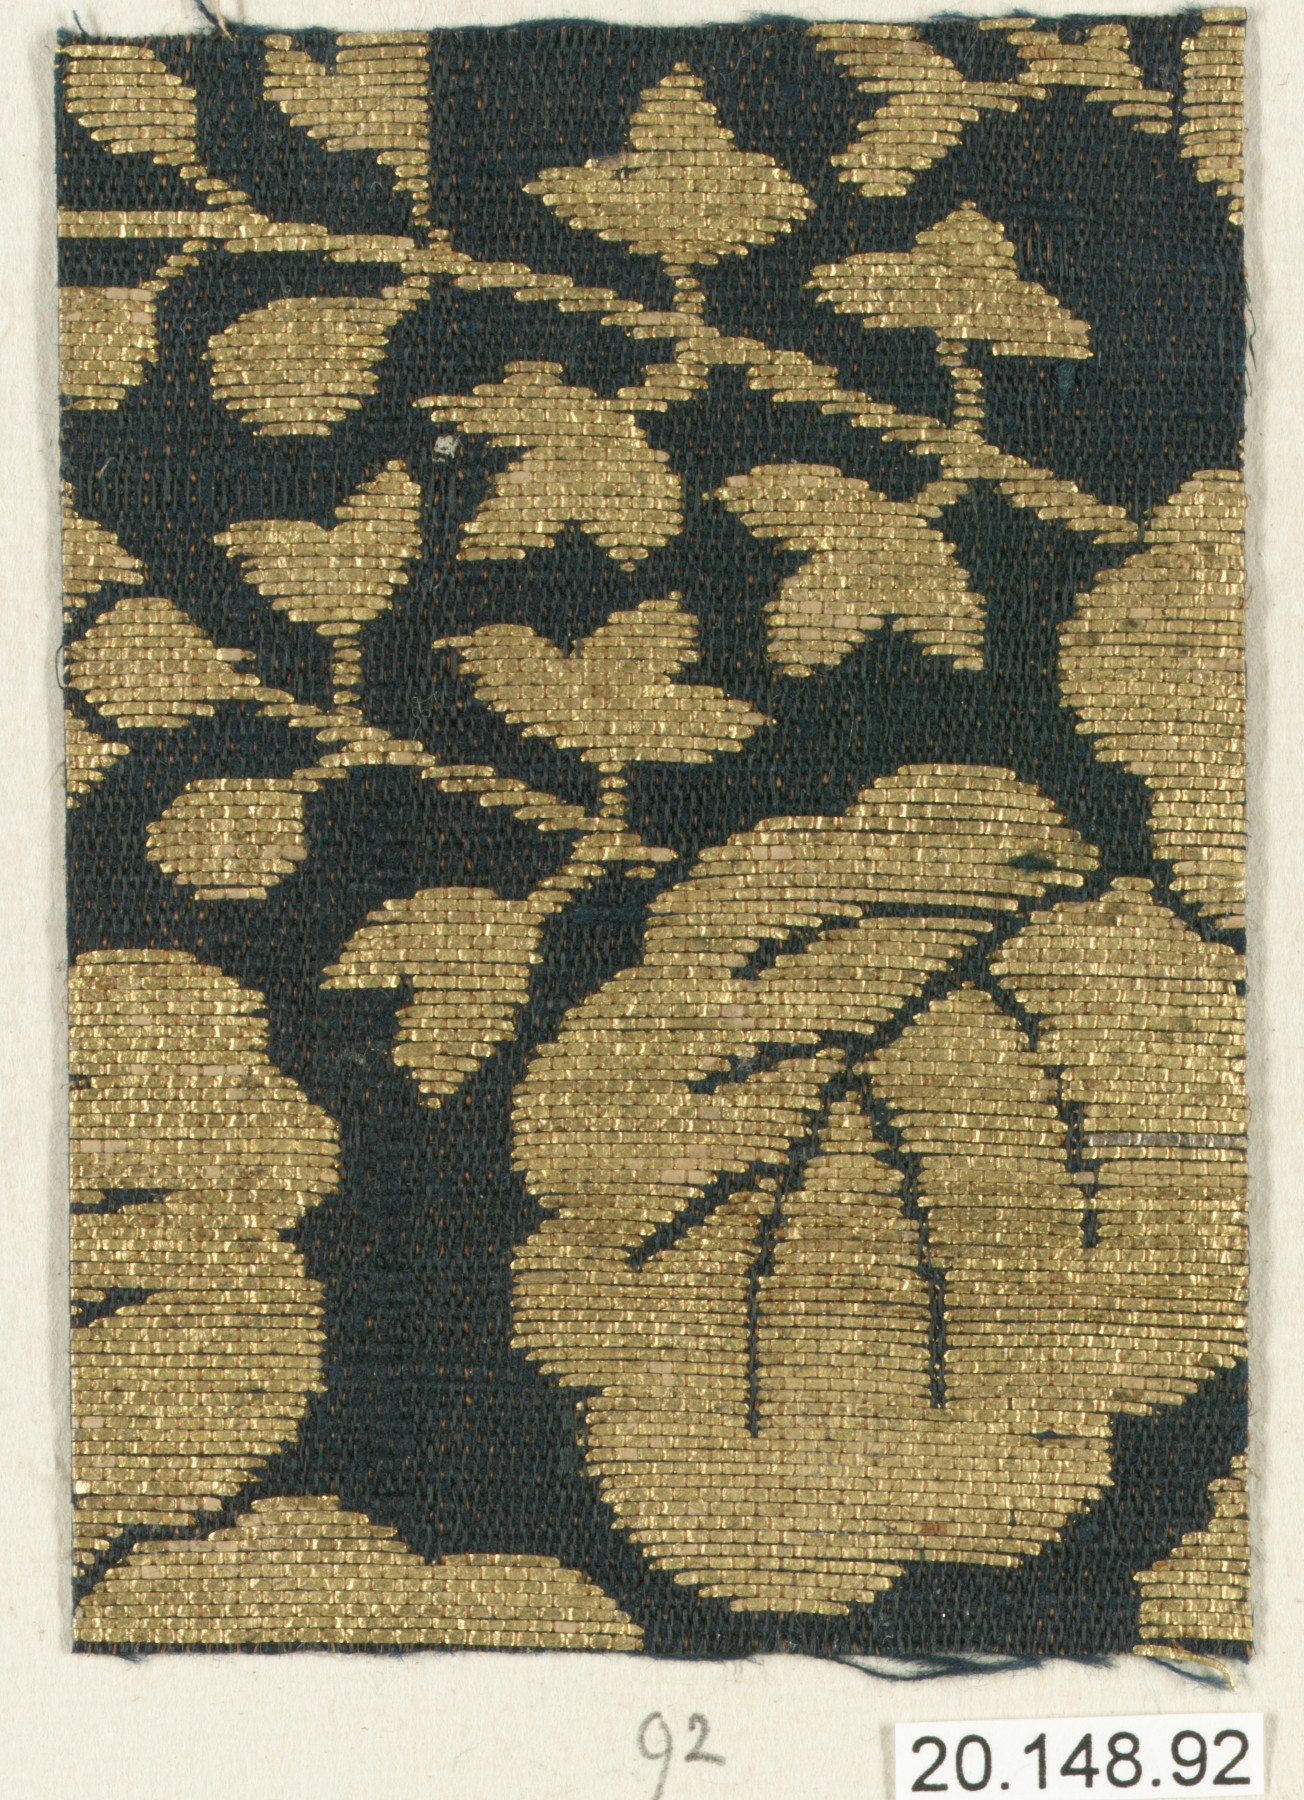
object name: piece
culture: japanese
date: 1601-1700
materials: silk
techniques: compound weave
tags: leaves